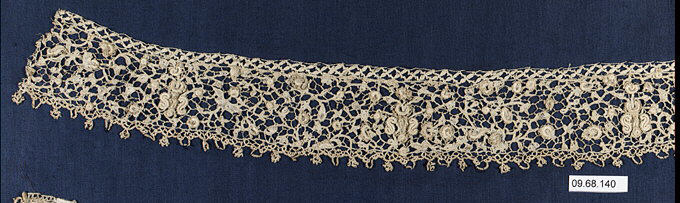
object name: border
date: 1601-1700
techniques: lace